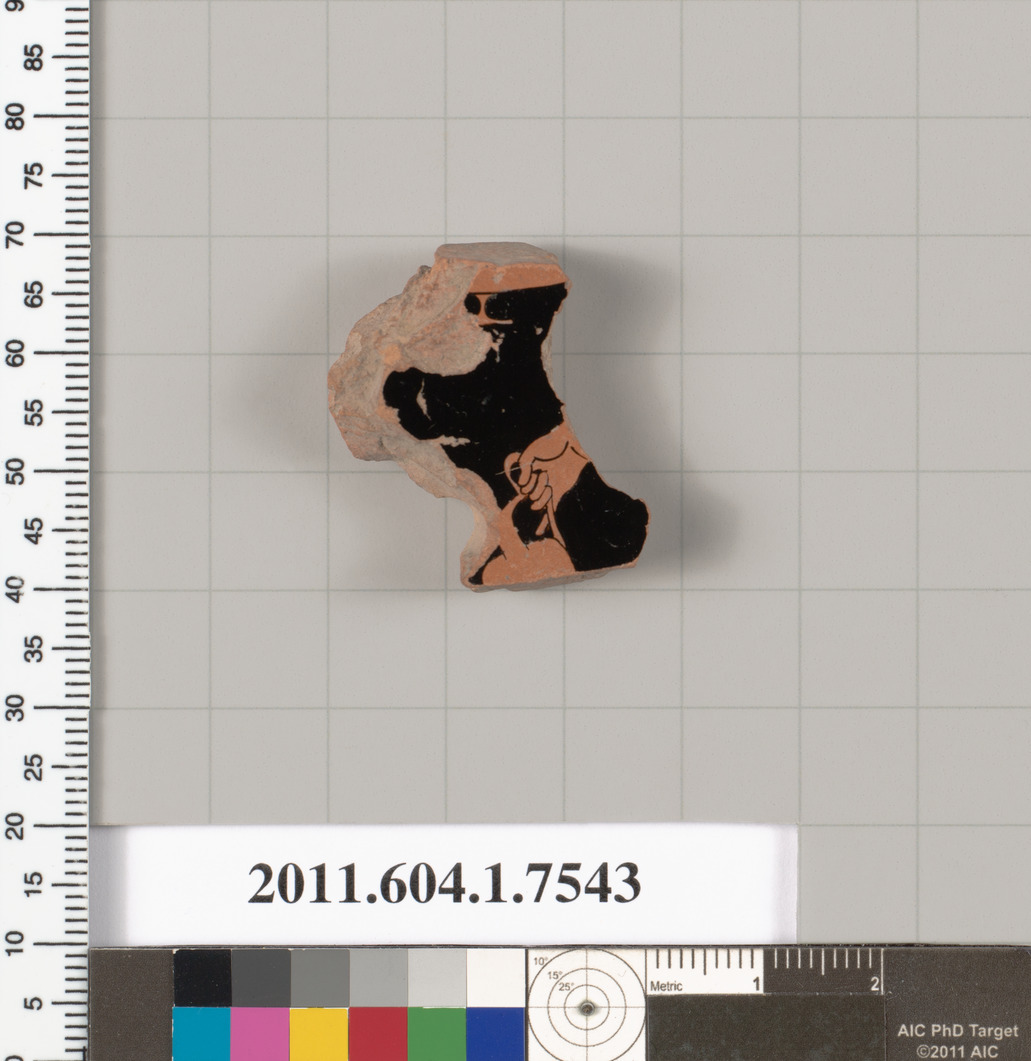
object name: kylix fragment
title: Terracotta fragment of a kylix (drinking cup)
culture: greek, attic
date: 460-450 BCE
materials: terracotta